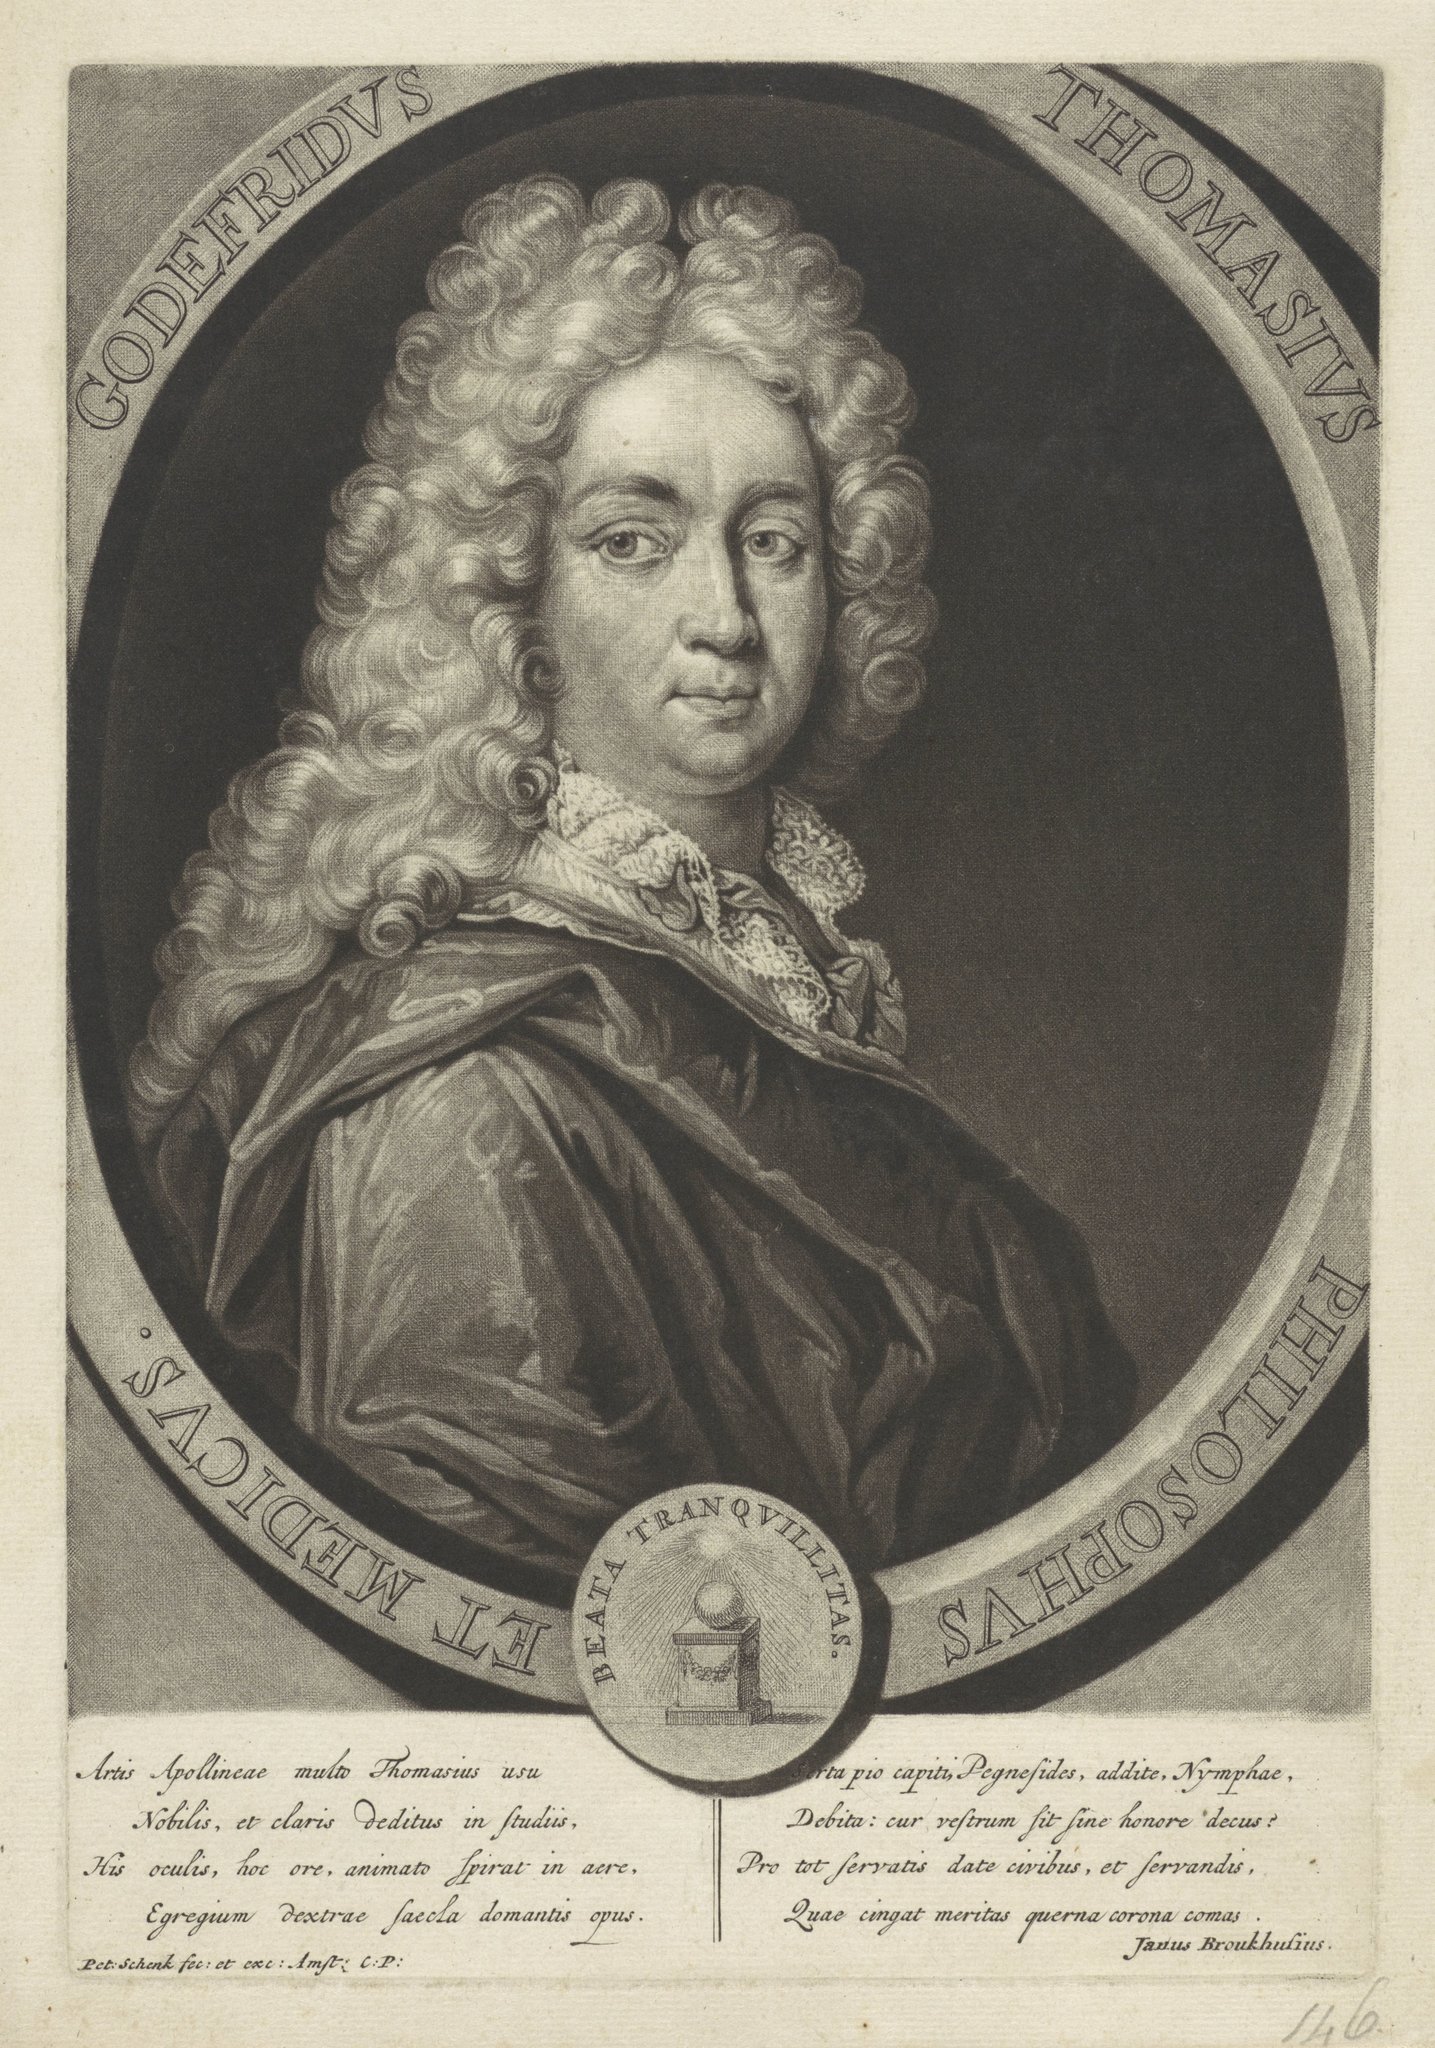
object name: print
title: Portret van Godfried Thomas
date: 1670-1713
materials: paper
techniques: engraving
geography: amsterdam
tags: wig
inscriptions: collector's mark: Lugt 2228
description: Godfried Thomas, arts te Neurenberg. Hij draagt een pruik.